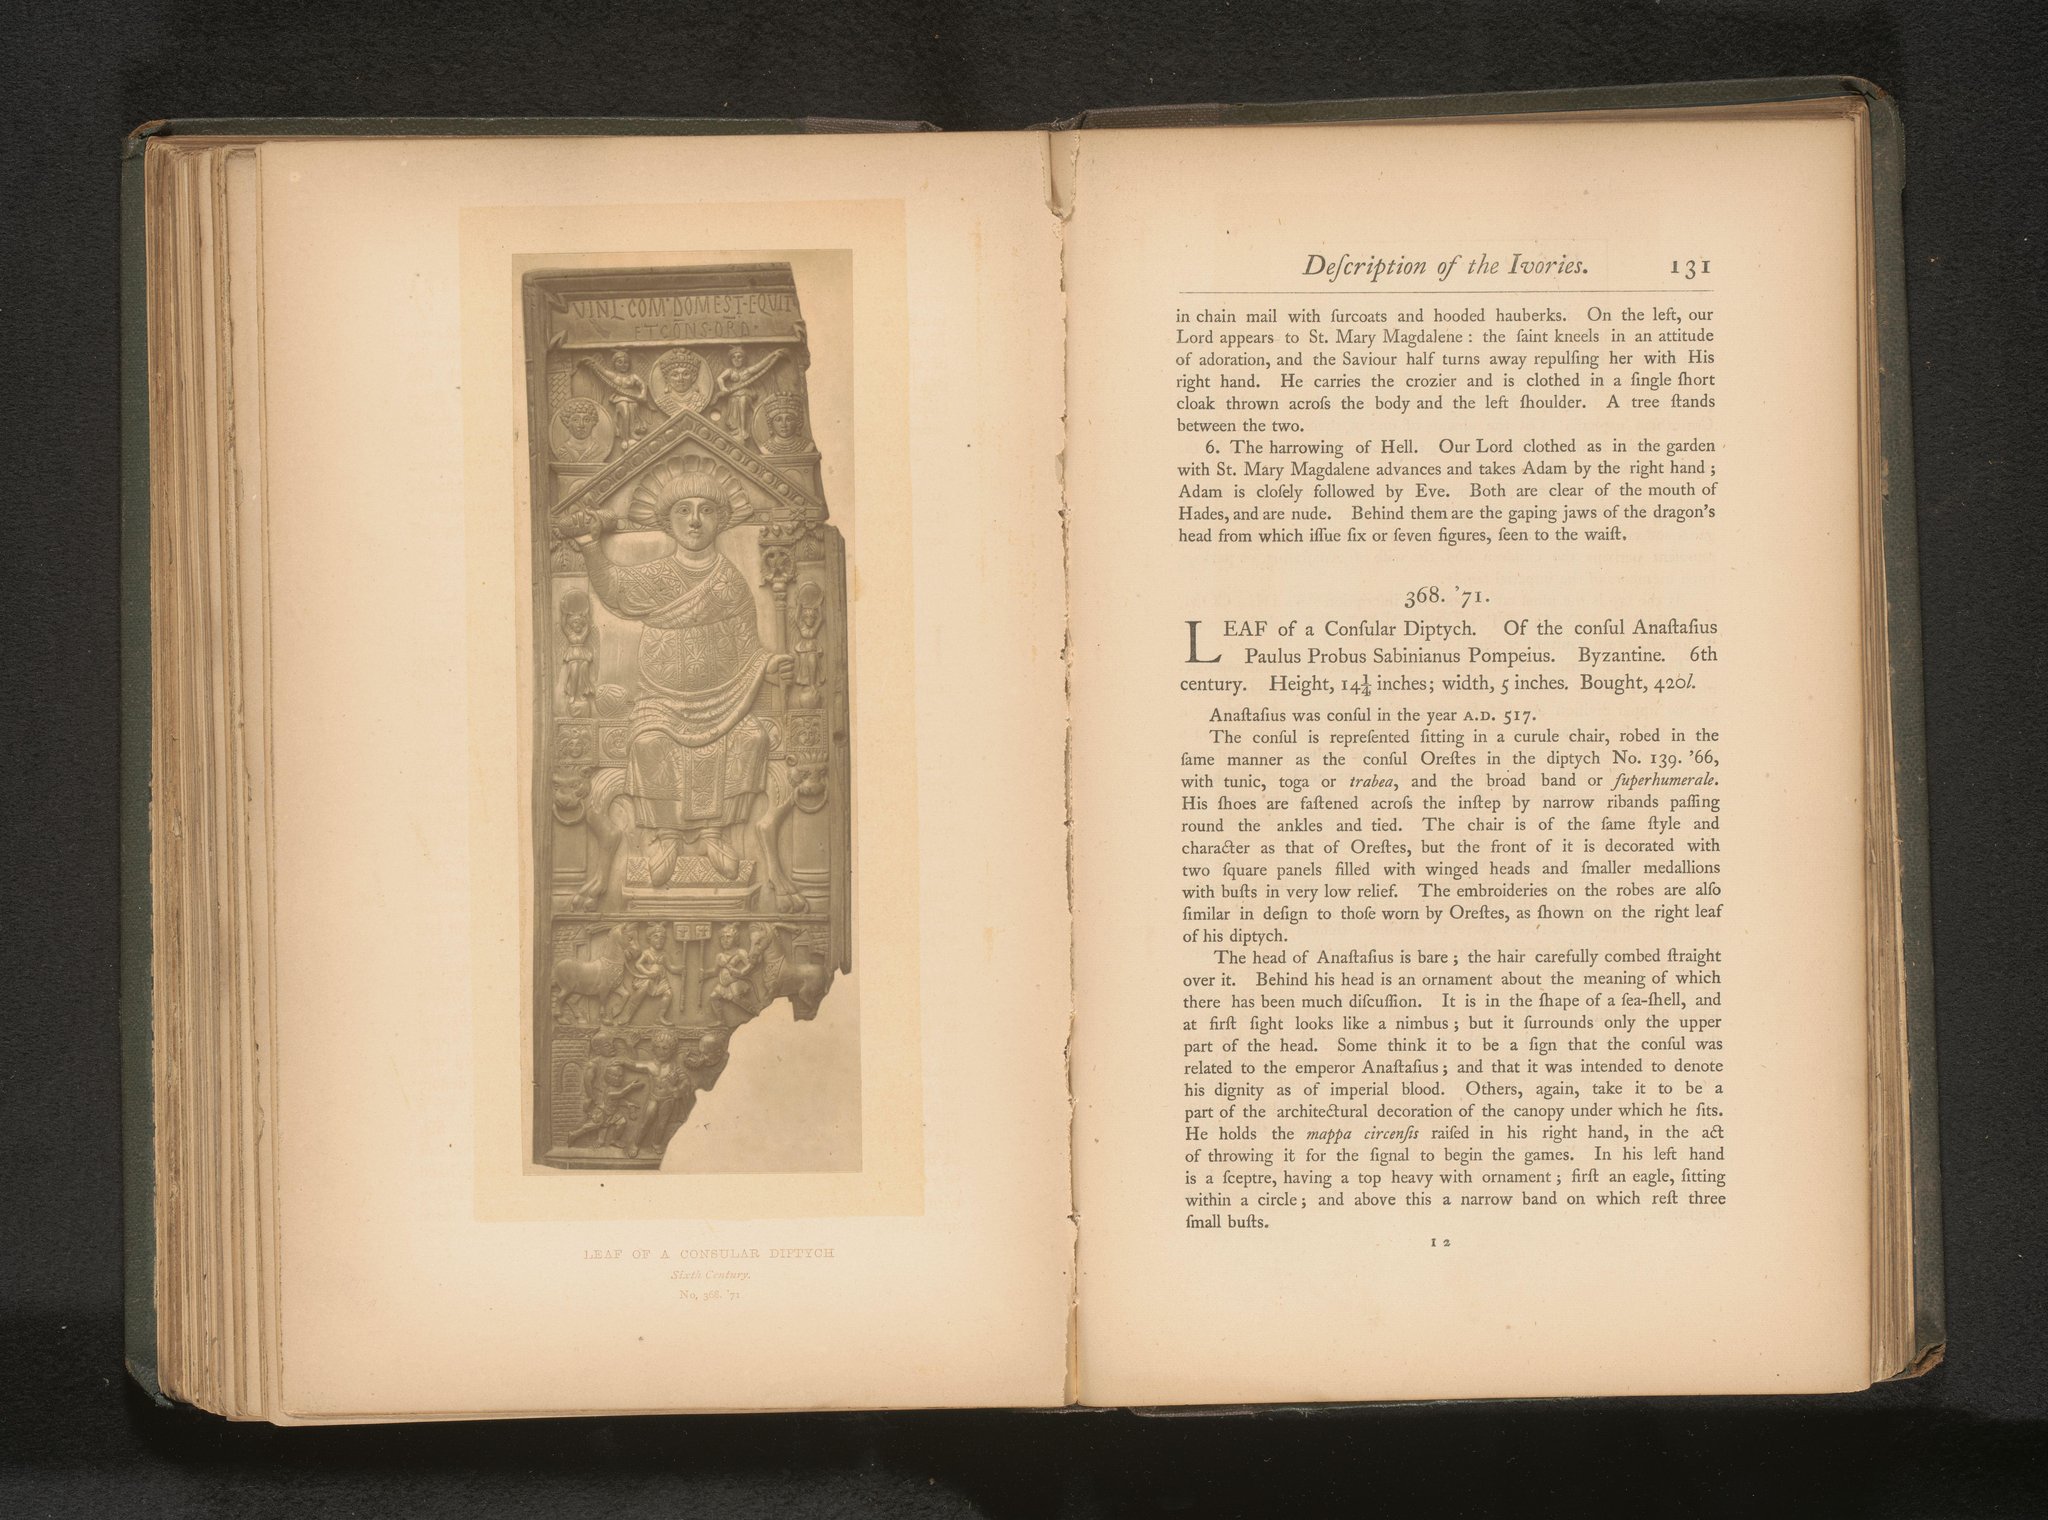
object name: page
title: Leaf of a consular diptych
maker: Anonymous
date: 1867-1872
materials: paper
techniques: woodburytype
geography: london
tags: official; civil servant; functionary (in general), sculpture (+ relief ~ sculpture)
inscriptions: inscription: ‘Sixth Century.’, number: ‘No. 368 '71.’